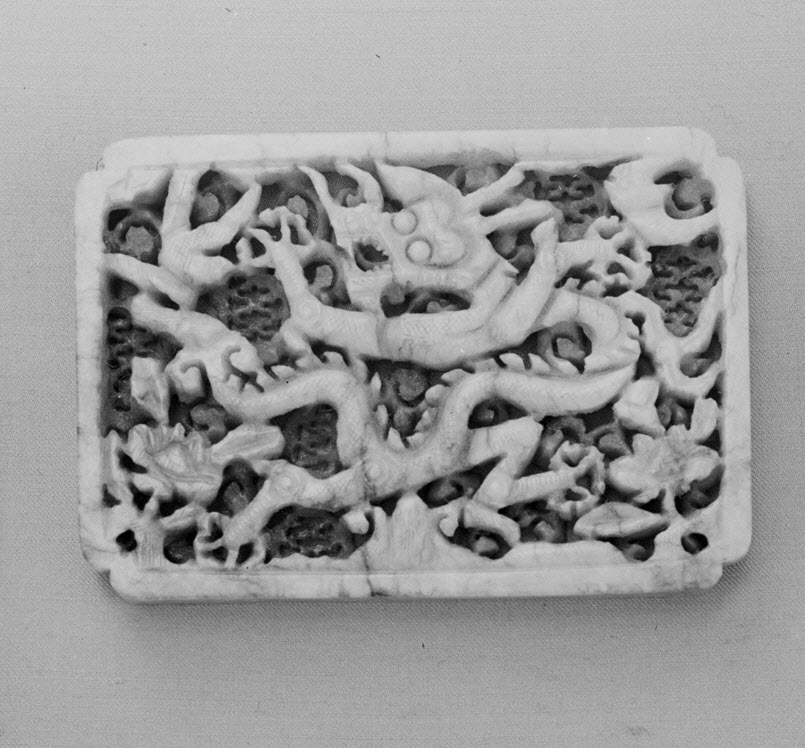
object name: belt plaque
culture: chinese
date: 1368-1644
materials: jade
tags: dragons